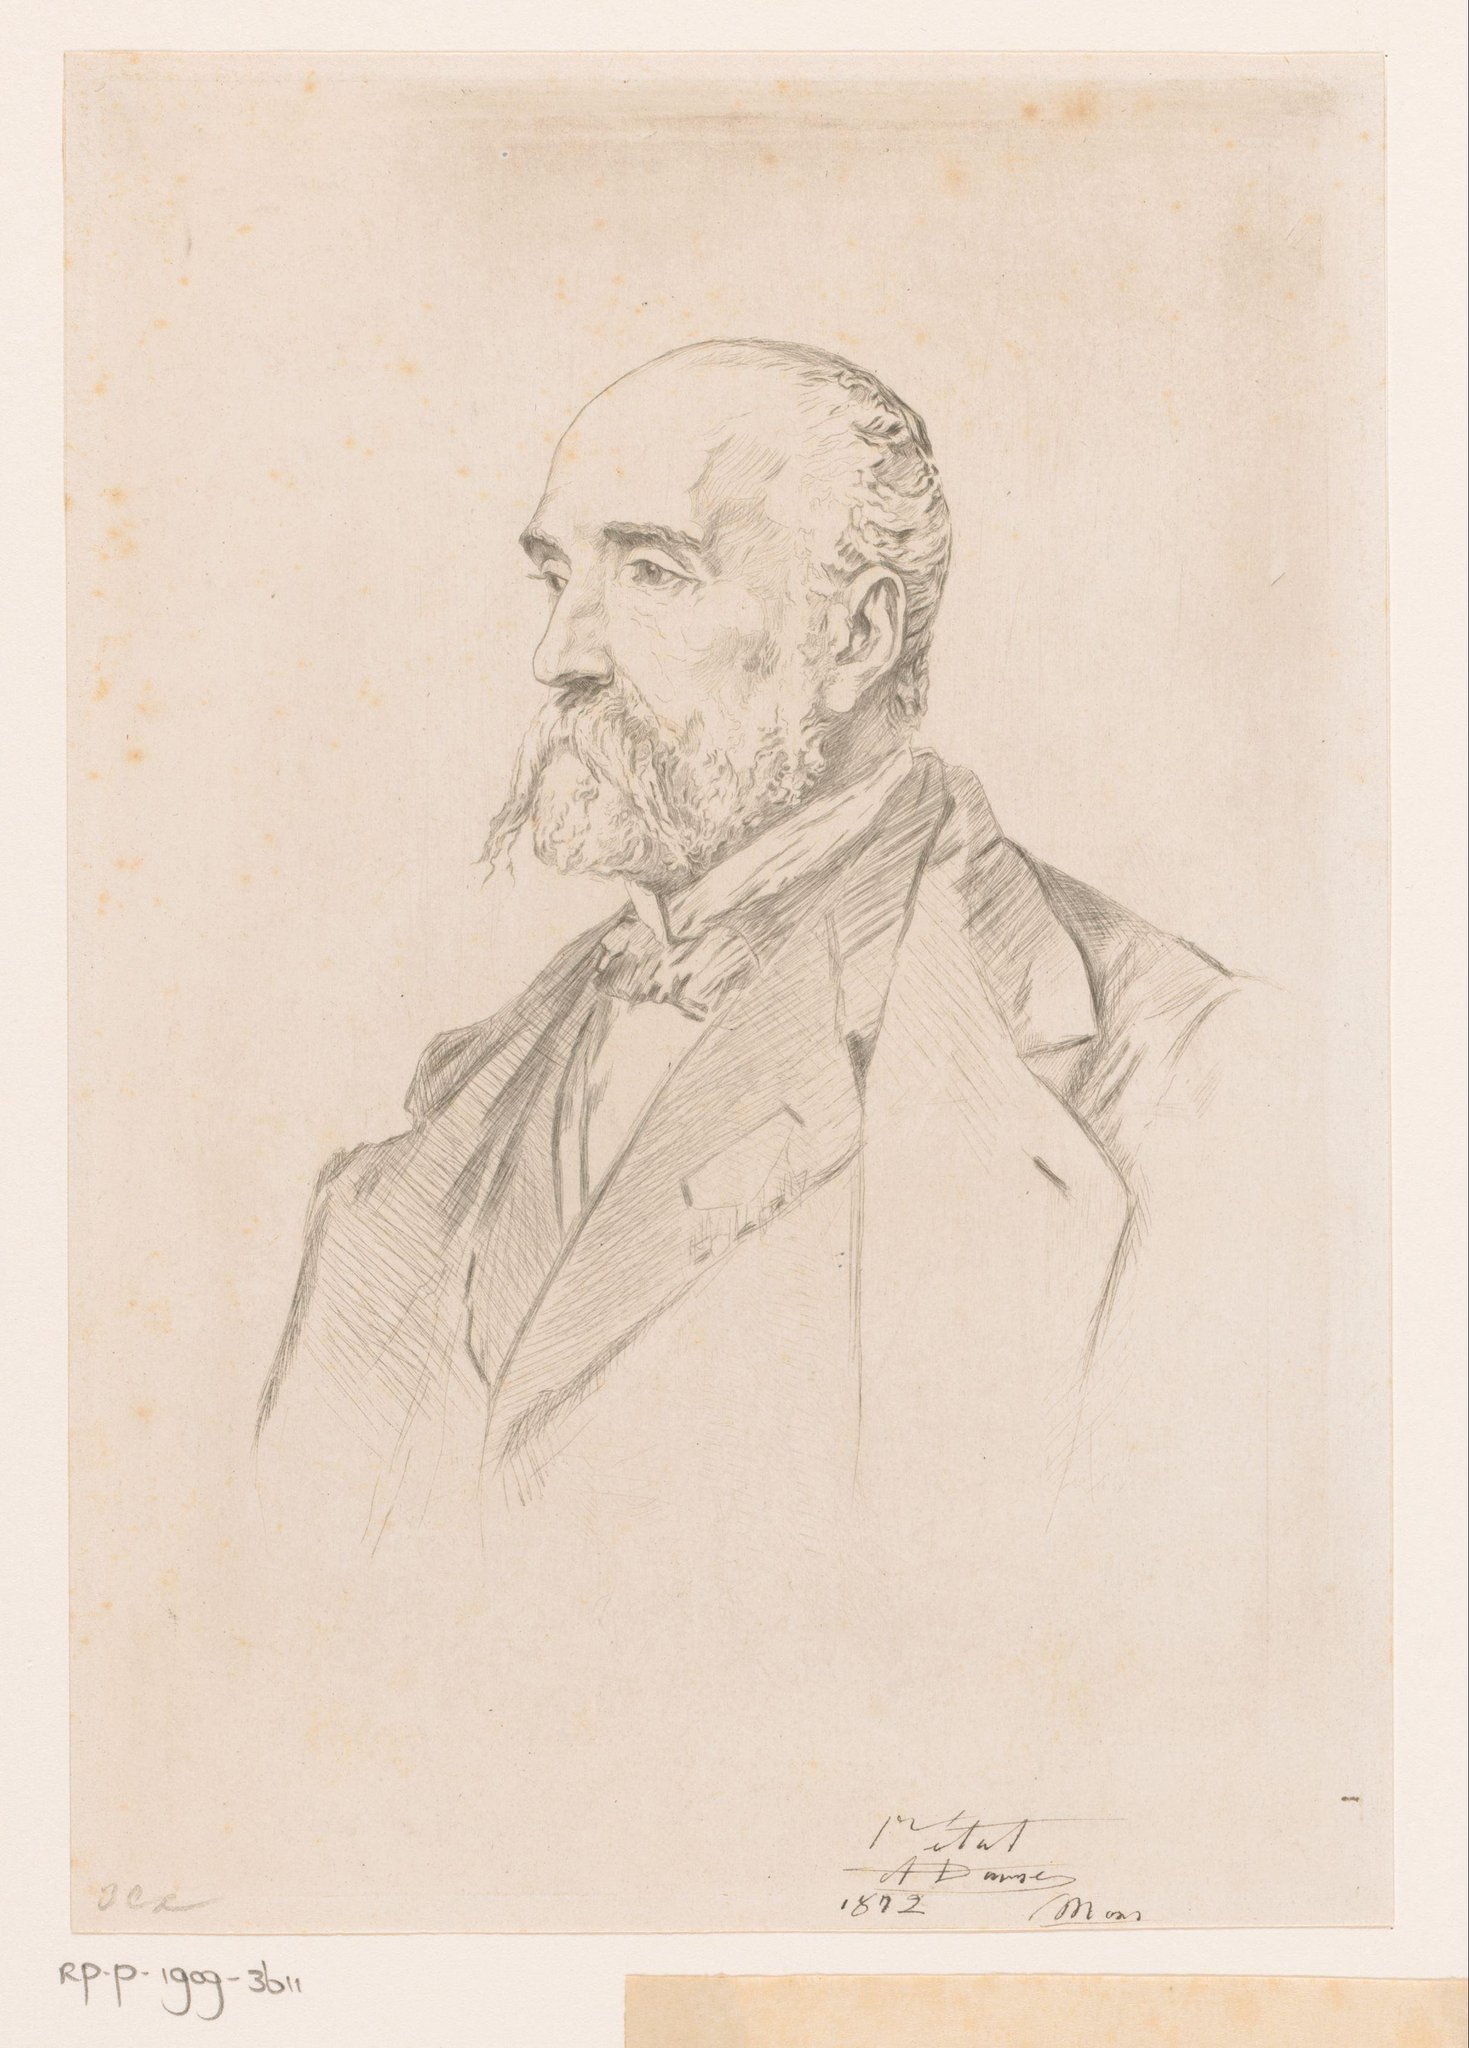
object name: print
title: Portret van een onbekende man genaamd Ohnet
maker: auguste danse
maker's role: print maker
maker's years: 1829-1929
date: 1872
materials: paper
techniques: etching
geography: bergen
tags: anonymous historical person portrayed alone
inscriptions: annotation: ‘1er état’, annotation: ‘3 ex’, collector's mark: Lugt 2228